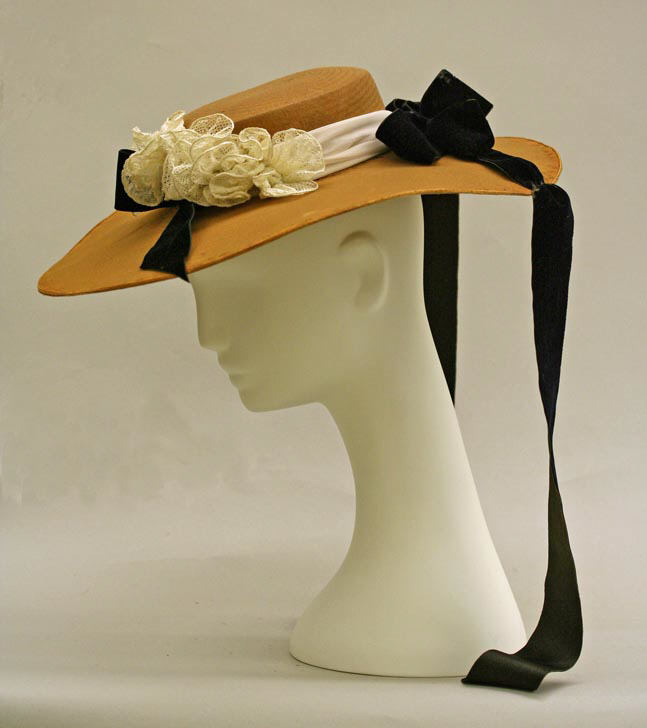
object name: hat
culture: american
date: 1834-1866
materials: fiber